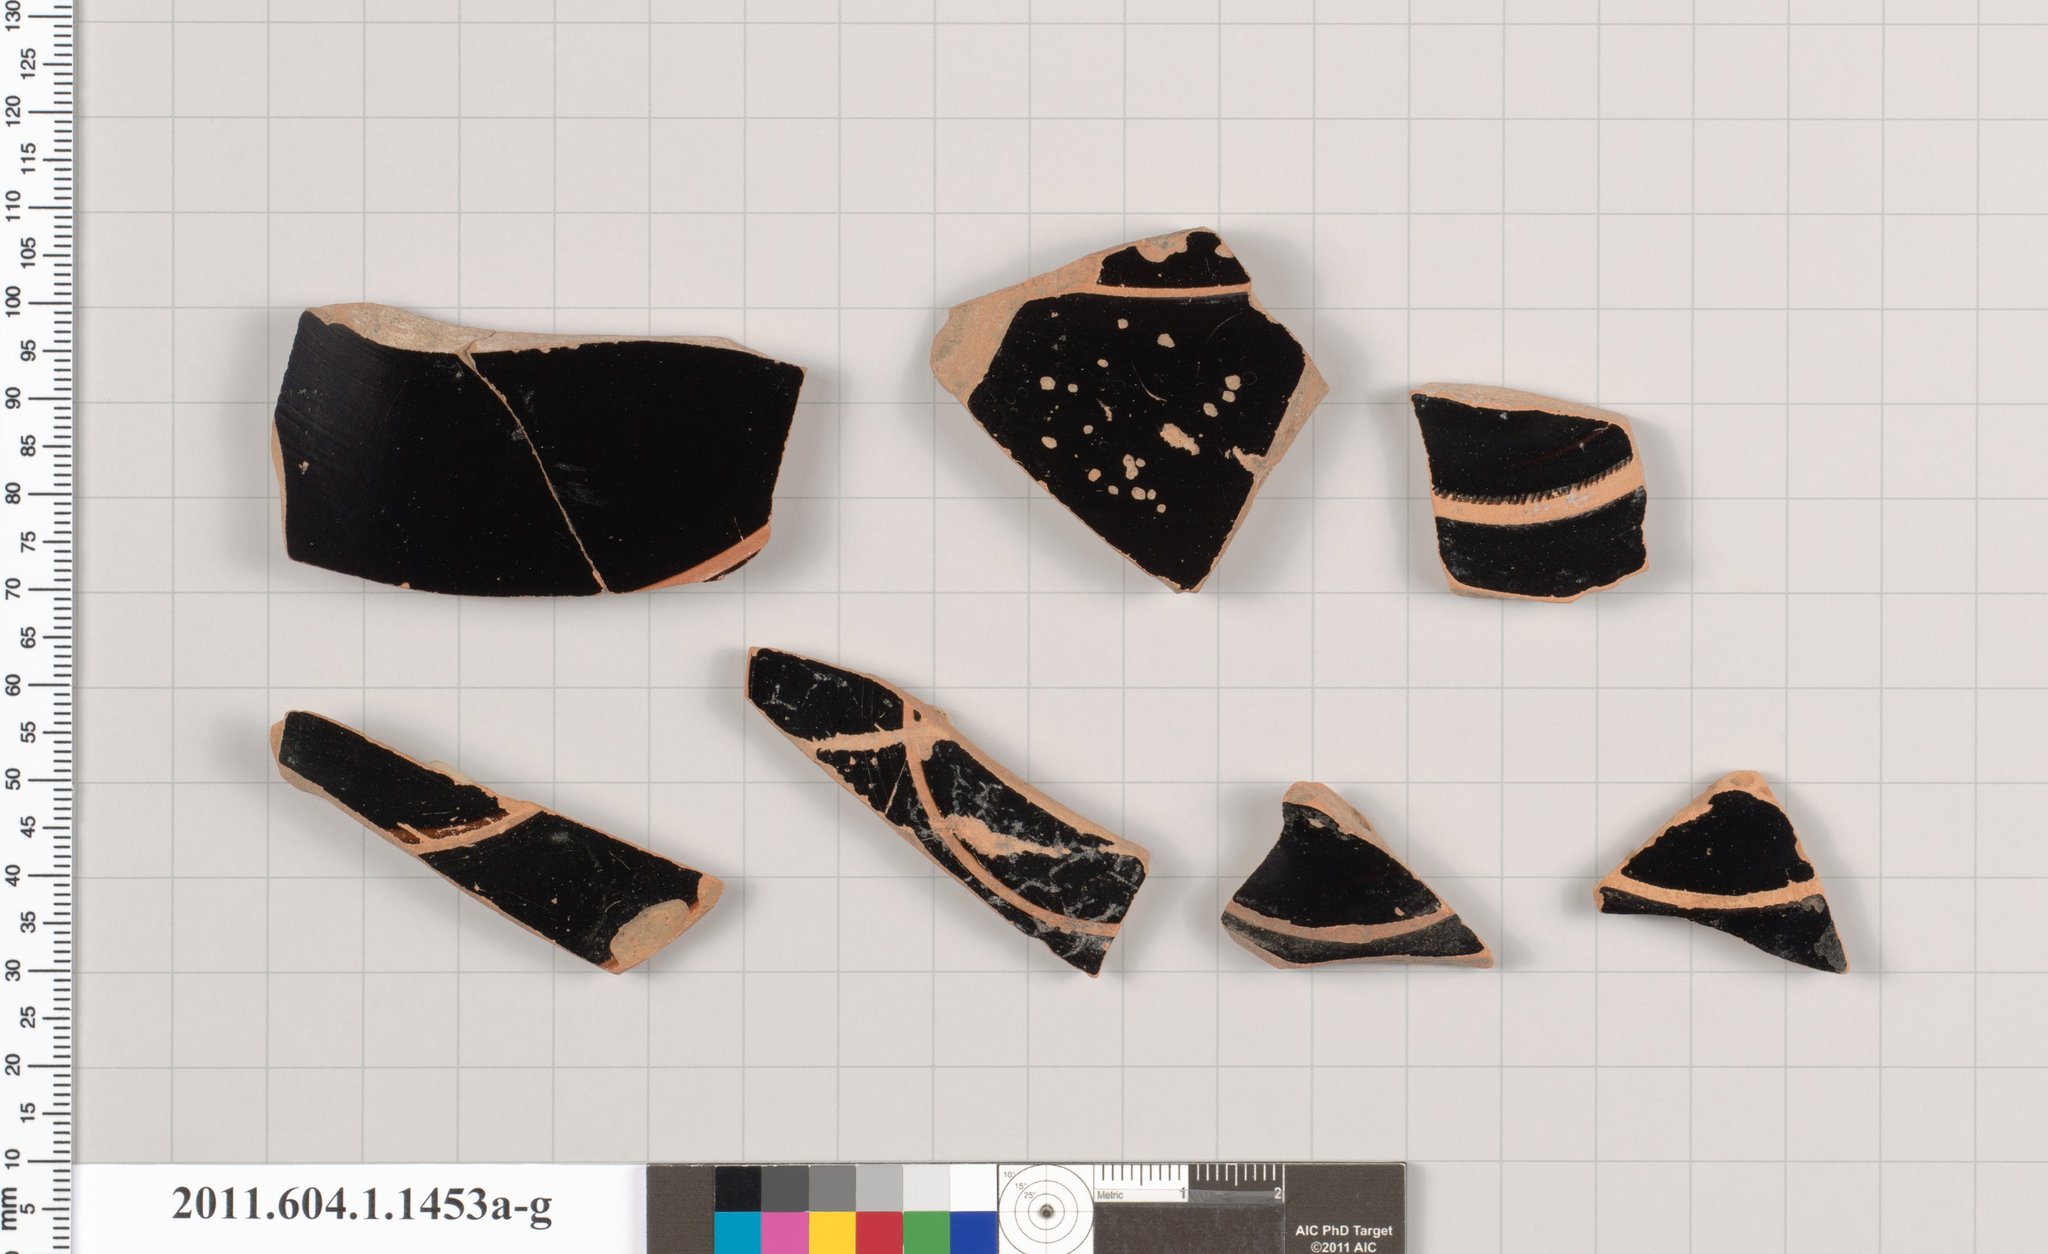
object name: kylix fragment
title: Terracotta fragments of kylikes (drinking cups)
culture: greek, attic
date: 500-401 BCE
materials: terracotta